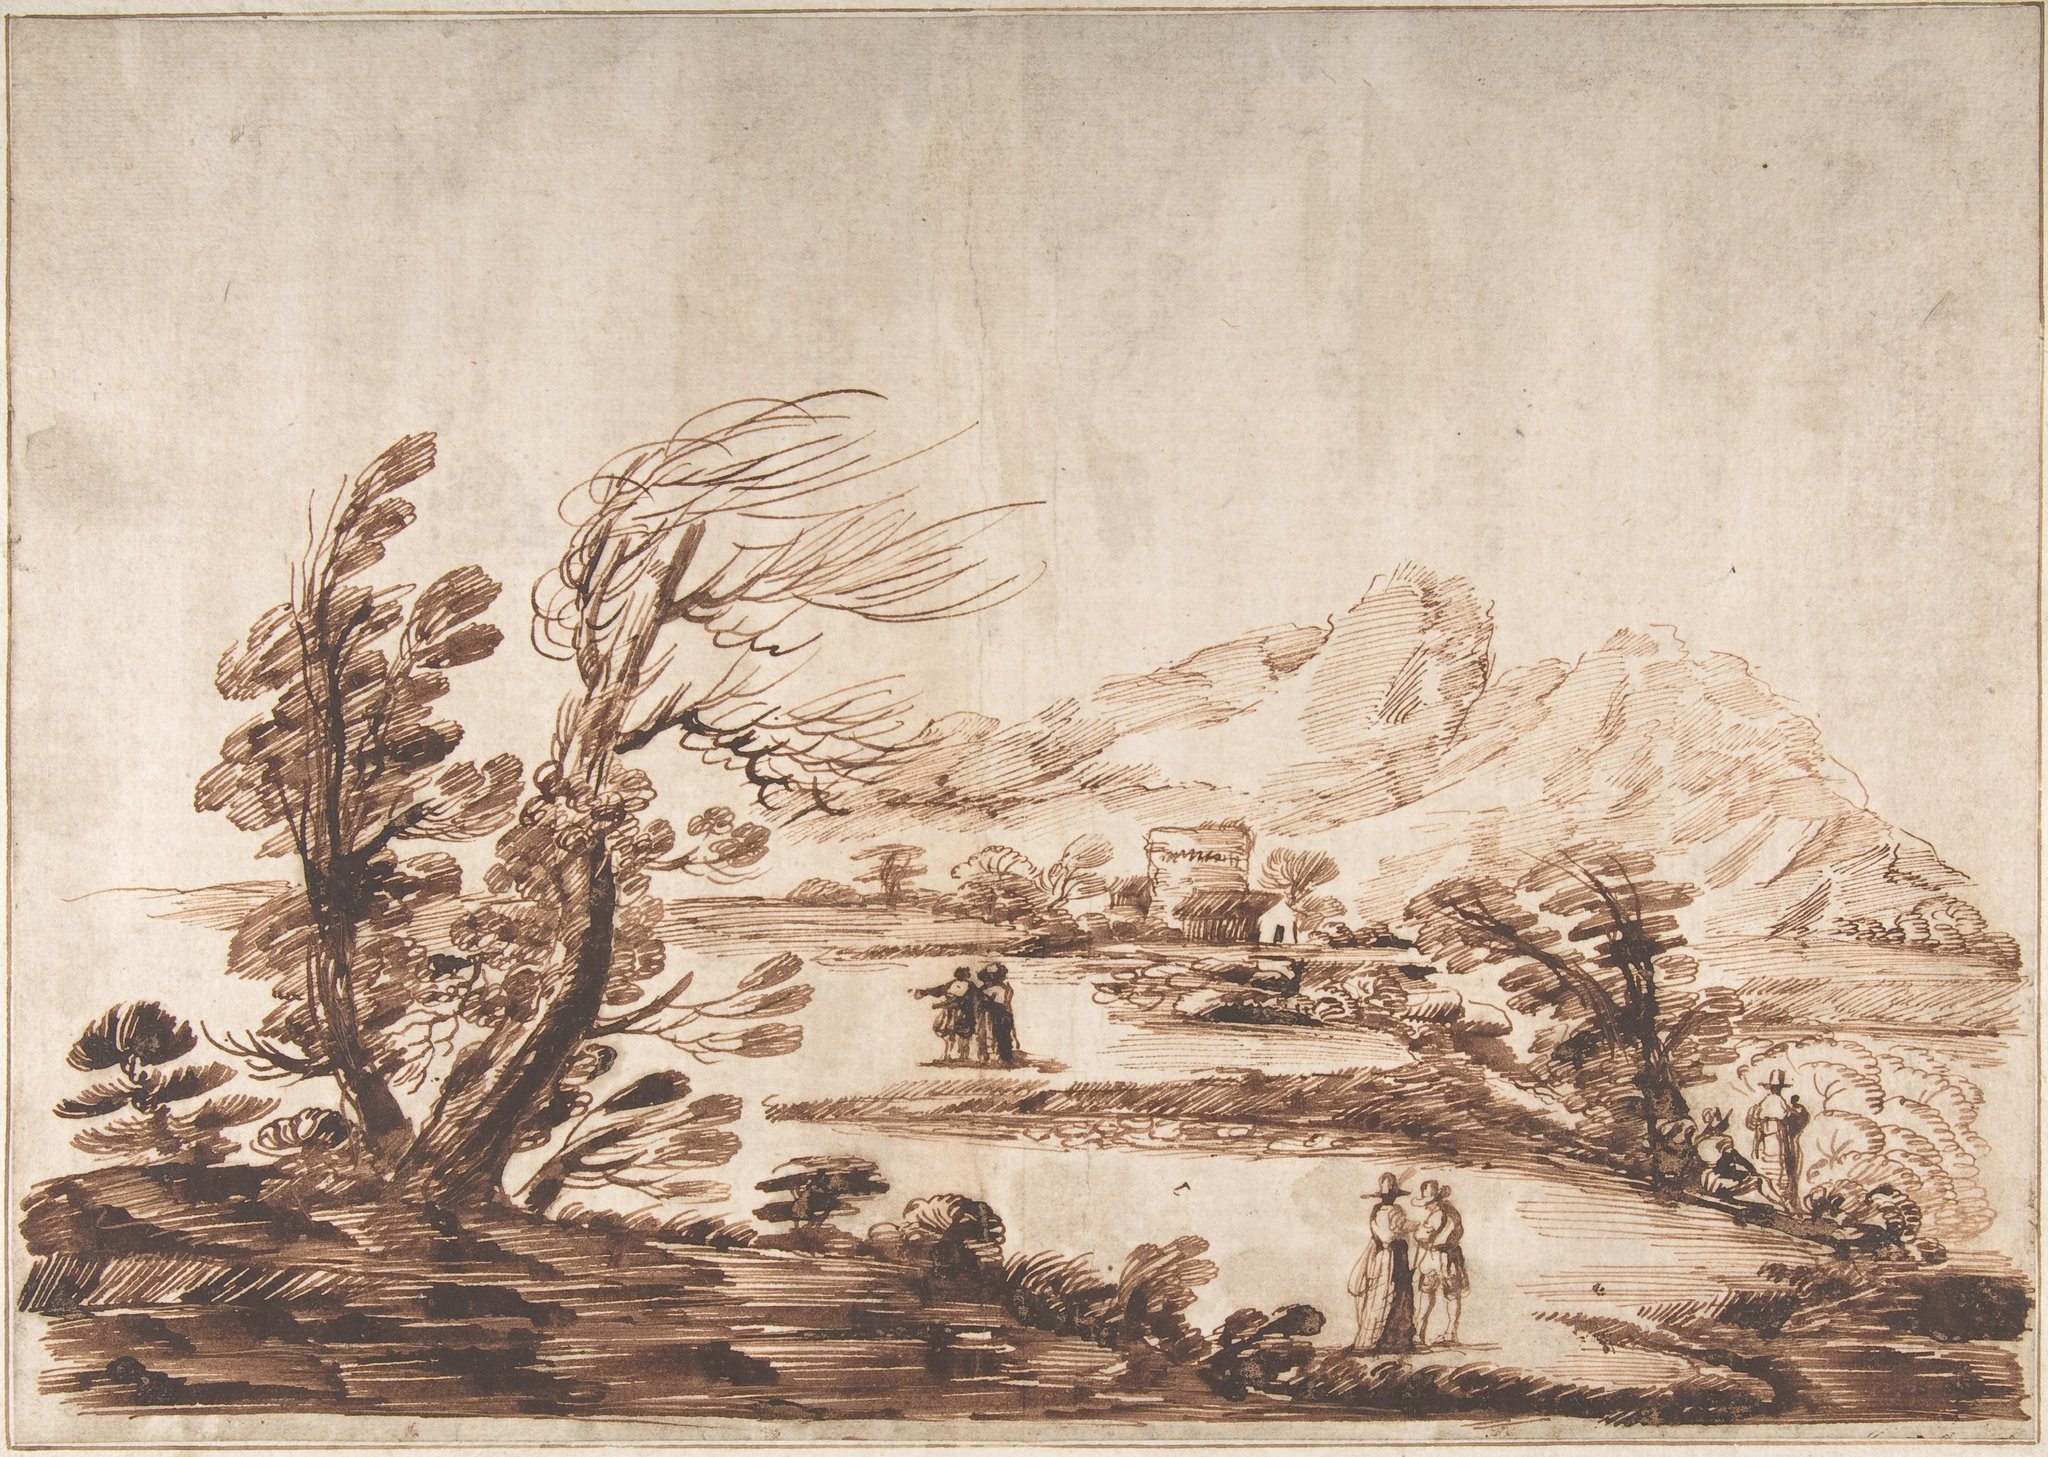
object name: drawing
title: Landscape with Six Figures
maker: guercino (giovanni francesco barbieri)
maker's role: artist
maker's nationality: italian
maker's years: 1591-1666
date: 1750-1780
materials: ink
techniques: brush, pen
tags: men,women,landscapes,trees